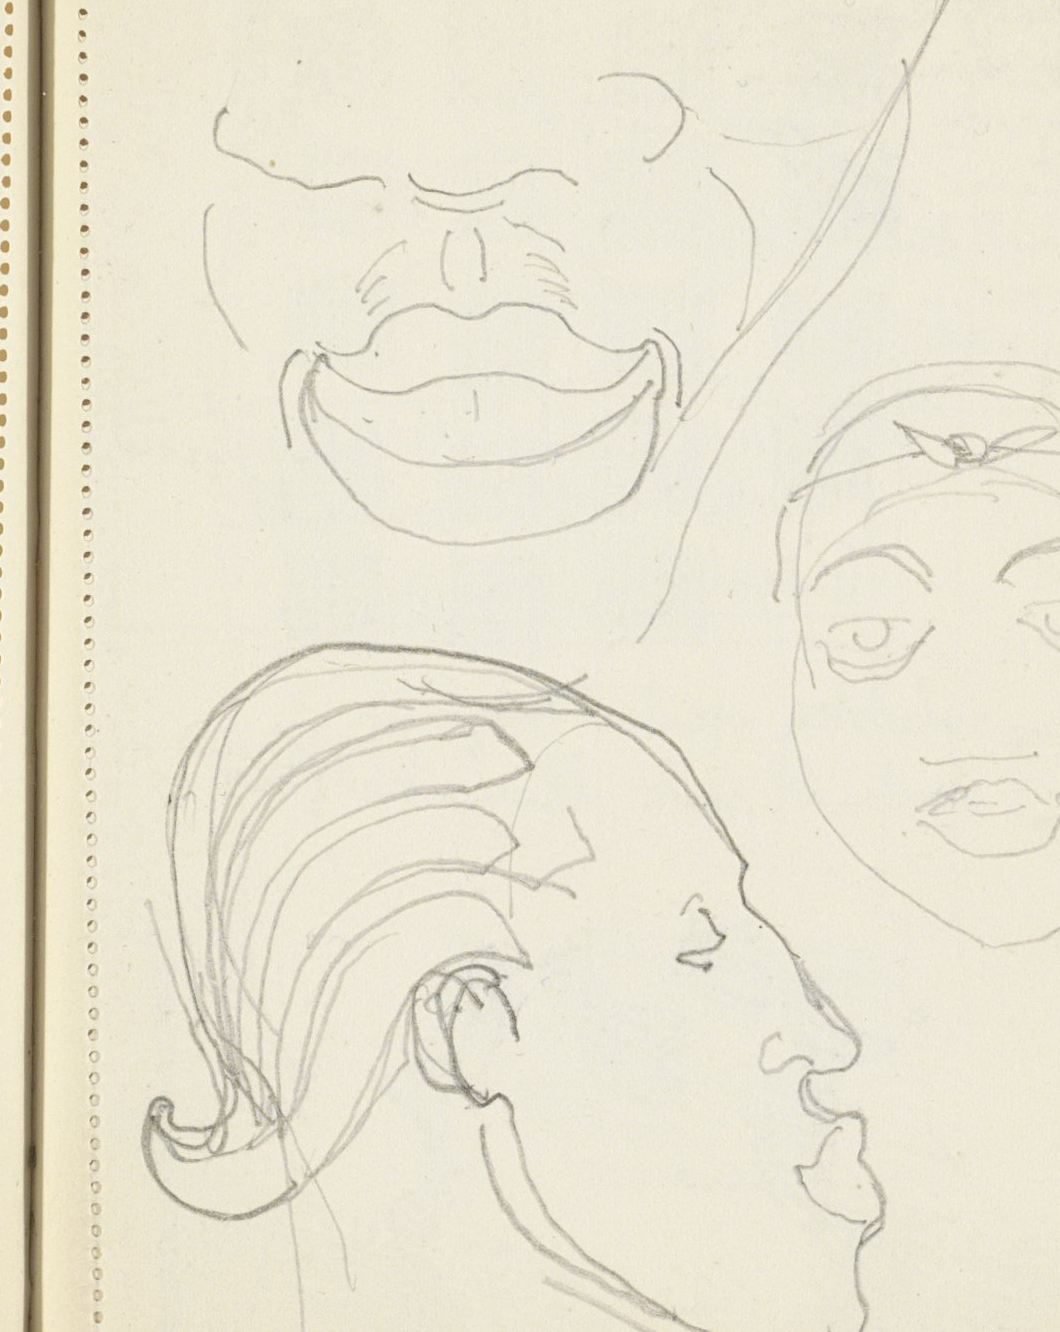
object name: sketchbook leaf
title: Hoofden van Afrikanen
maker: reijer stolk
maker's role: draughtsman, print maker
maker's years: 1896-1945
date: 1916-1945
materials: paper, pencil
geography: africa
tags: head (human), africans, mouth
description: Tevens een studie van een mond. Blad 37 recto uit een schetsboek met 60 bladen.